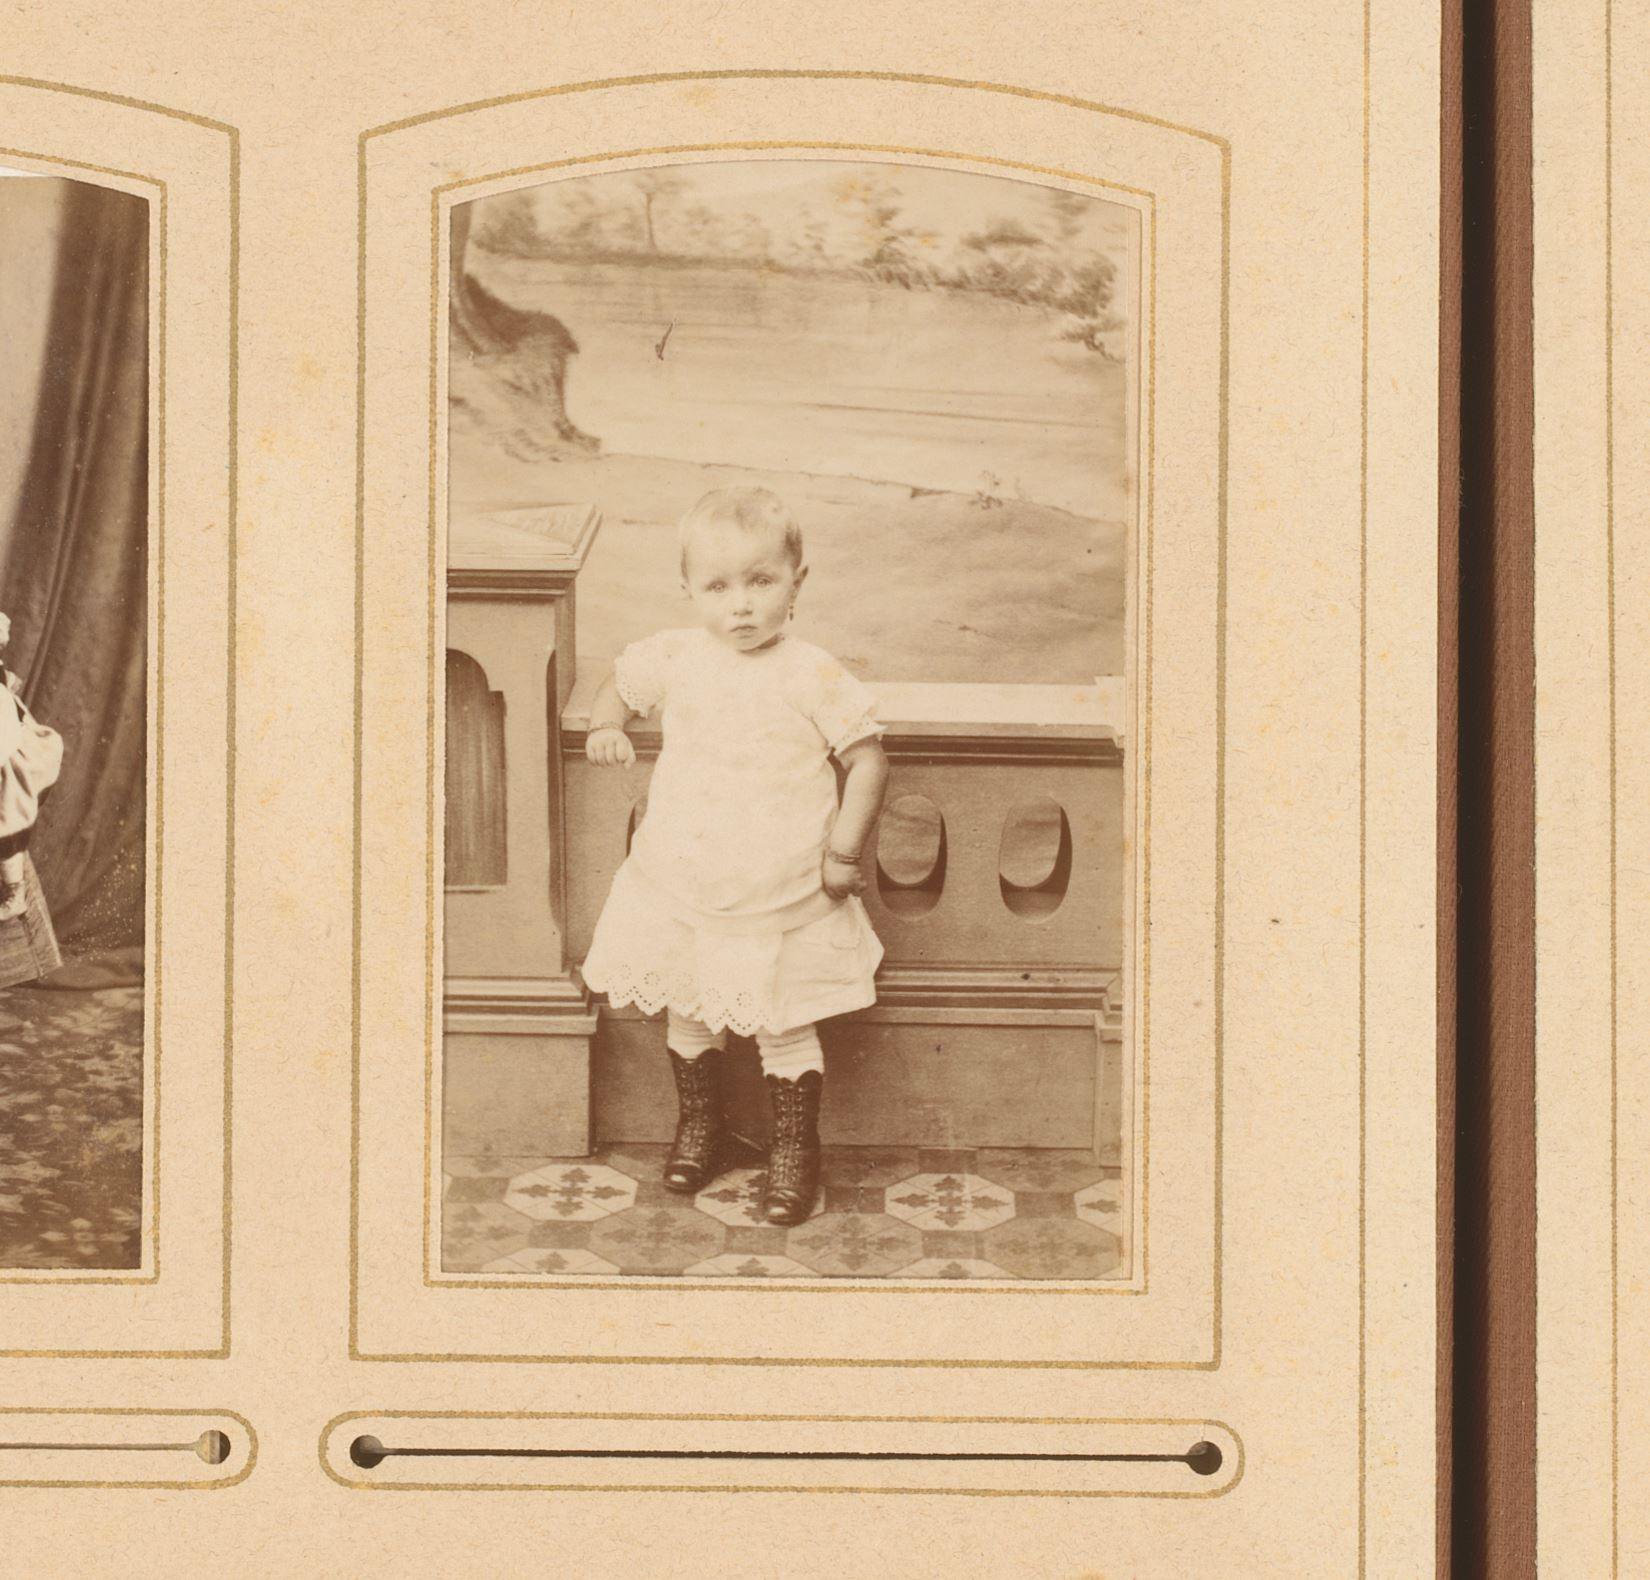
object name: carte de visite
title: Portret van een meisje, leunend op een balustrade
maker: Anonymous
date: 1860-1900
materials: cardboard, photographic support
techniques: albumen print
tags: historical persons - bb - woman, balustrade, toddler (female)